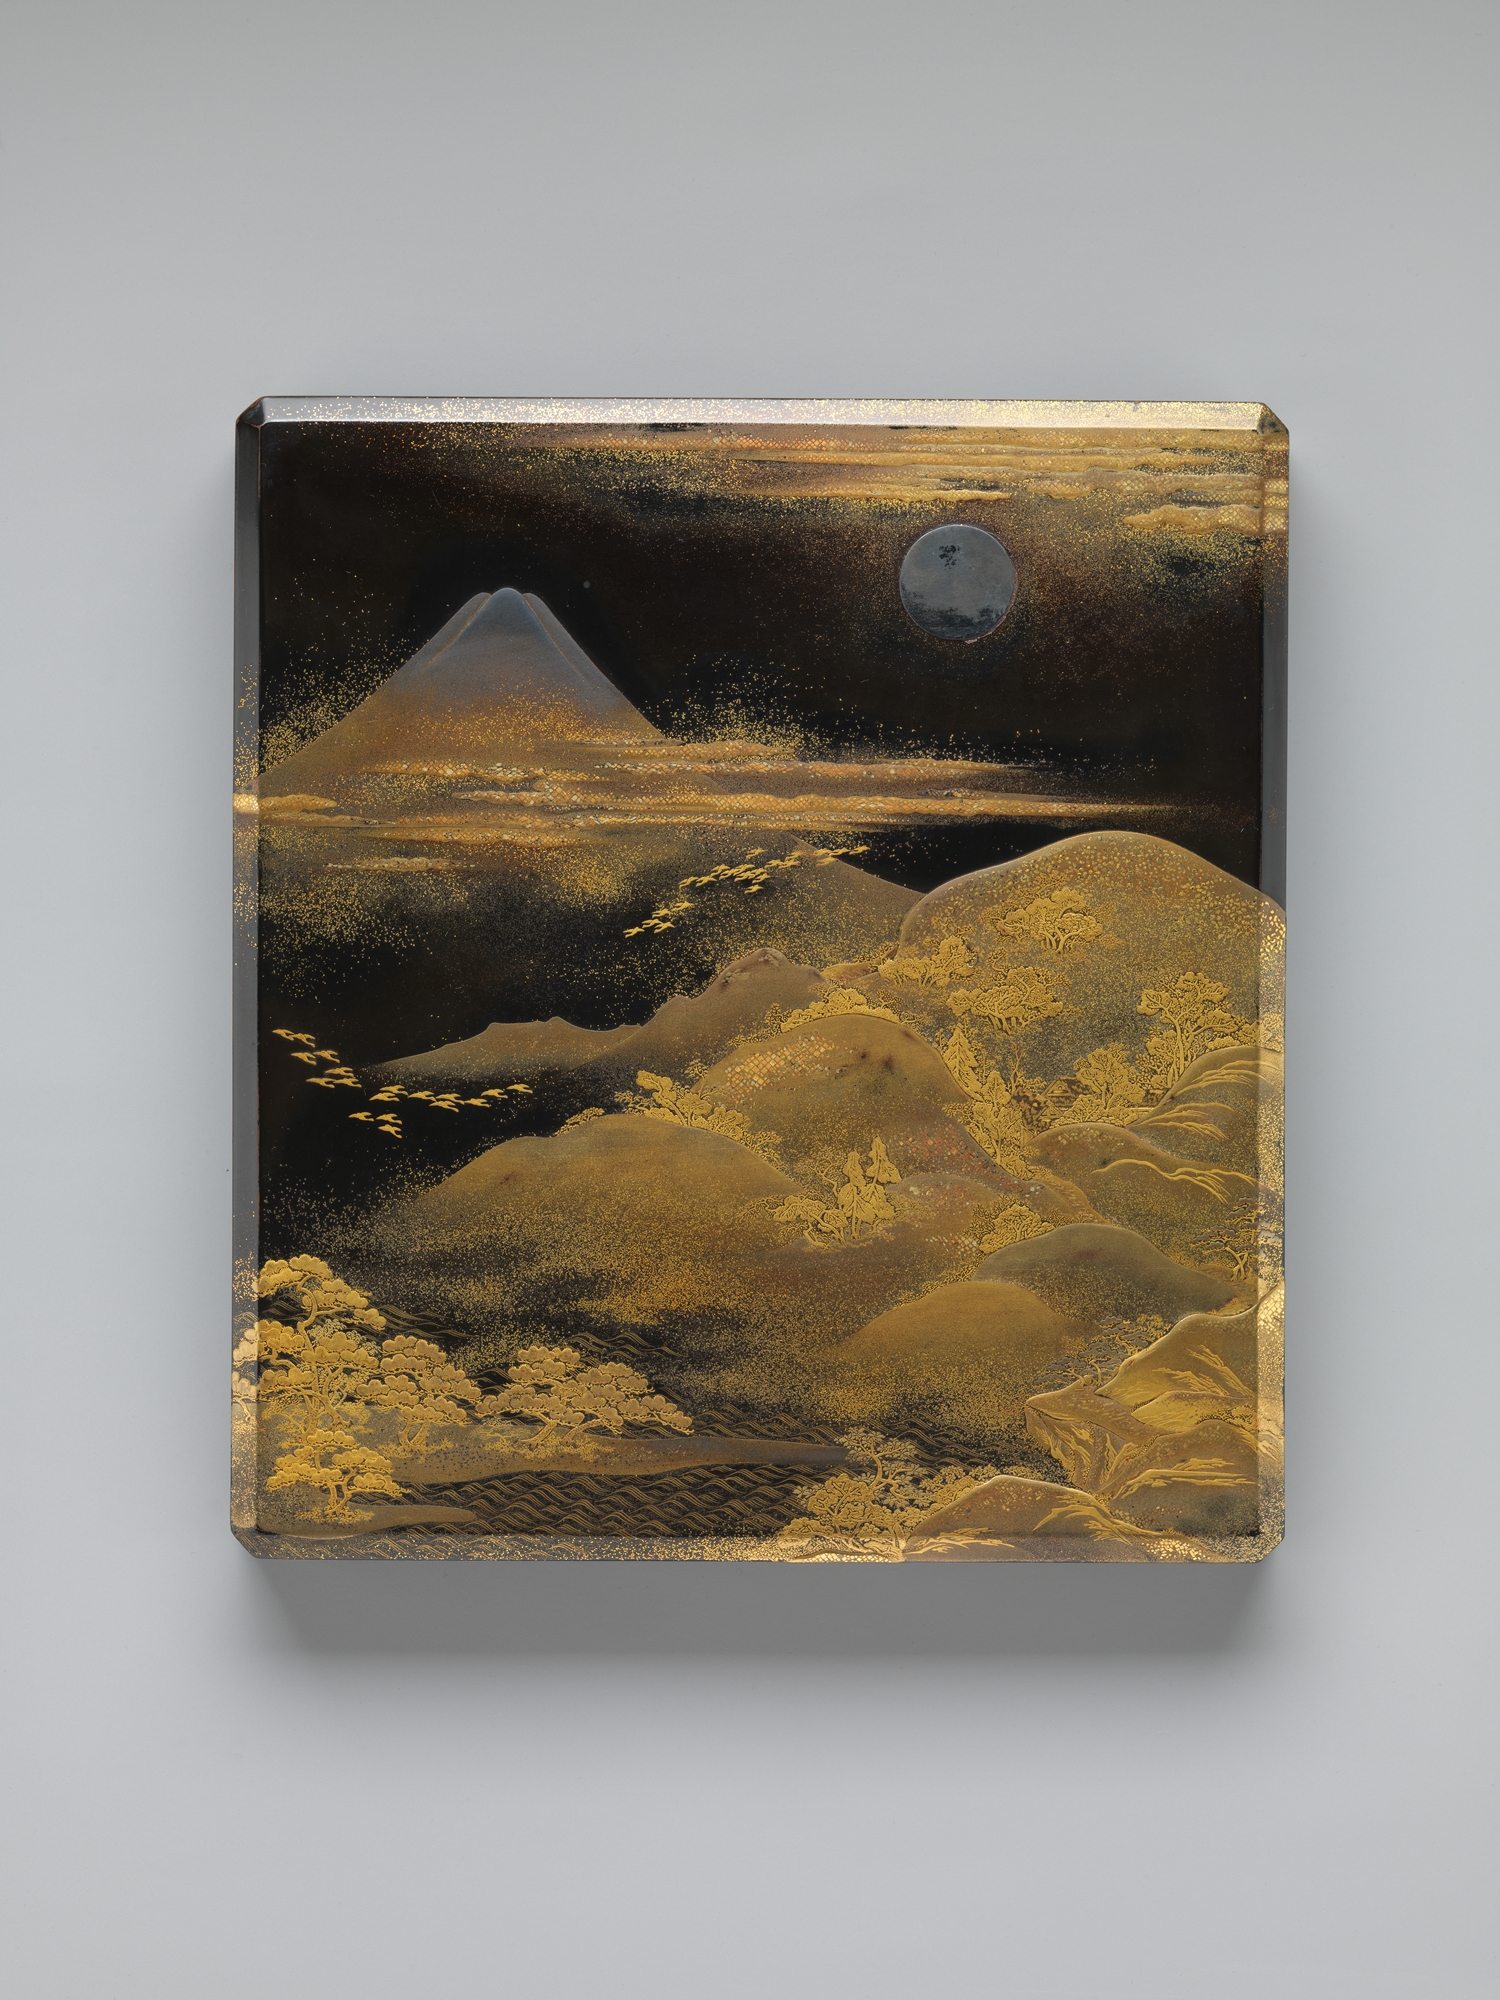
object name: writing box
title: Box for Inkstone and Writing Implements (Suzuribako) with Geese against Mount Fuji in Moonlight and (inner lid) with Plovers by the Seashore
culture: japanese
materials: gold, lacquer, silver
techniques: maki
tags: geese,moon,landscapes